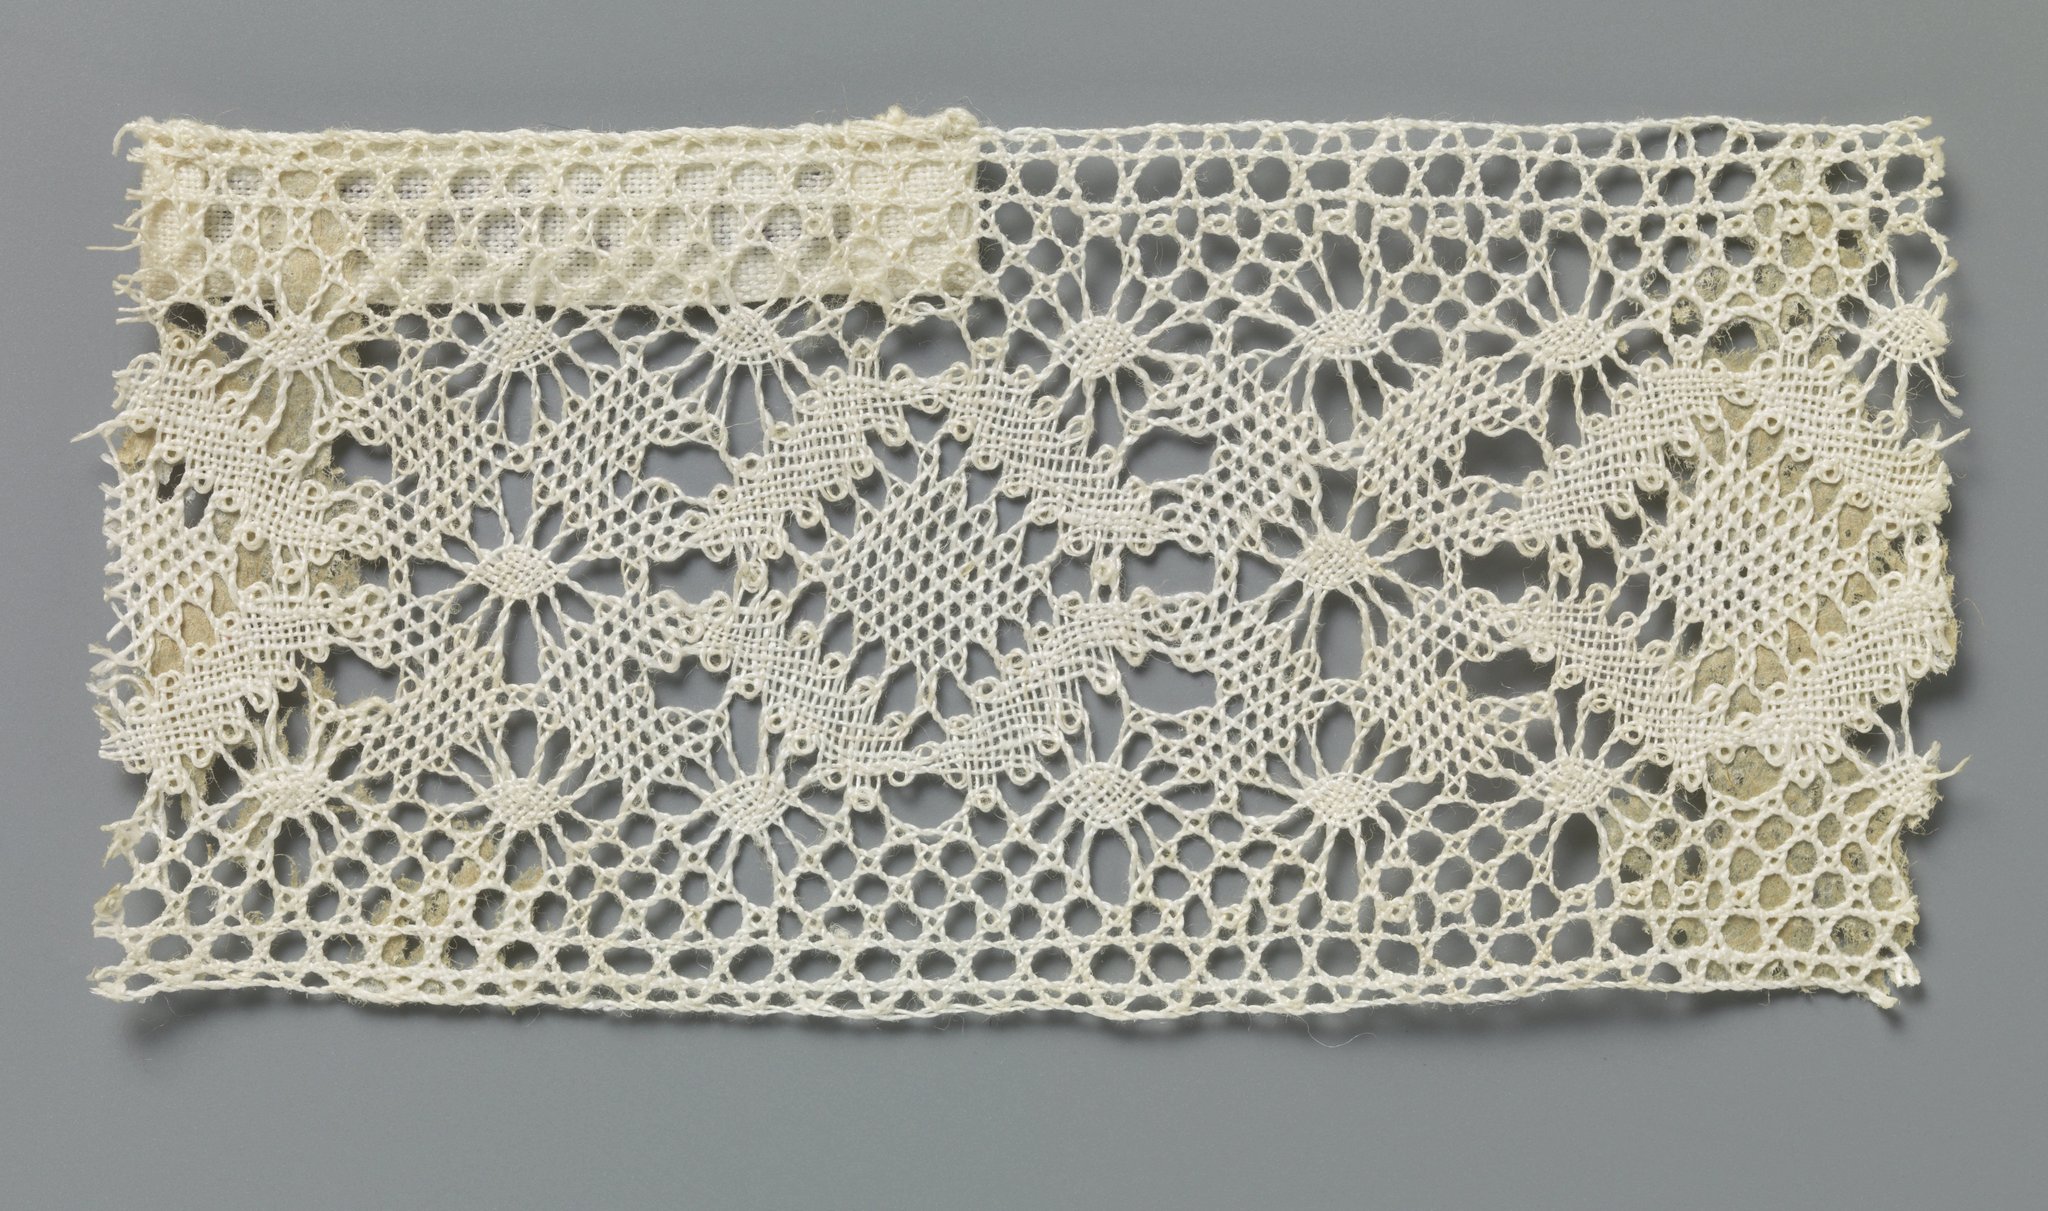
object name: strip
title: Tussenzetsel van kloskant met een rij ruiten omringd door spitsovaaltjes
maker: Anonymous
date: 1900-1924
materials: linen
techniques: lace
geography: russia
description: Strook naturelkleurig kloskant: stropkant. Het zich herhalende patroon bestaat uit een rij ruitjes omringd door spitsovaaltjes. De ruitjes zijn gemaakt in netslag met langs elke zijde een streep in linnenslag met een onderbreking bij de punten. De motieven zijn langs de onderzijde en de bovenzijde van de strook met elkaar verbonden door een stroptraliegrond. Boven- en onderzijde van de strook zijn recht afgewerkt.